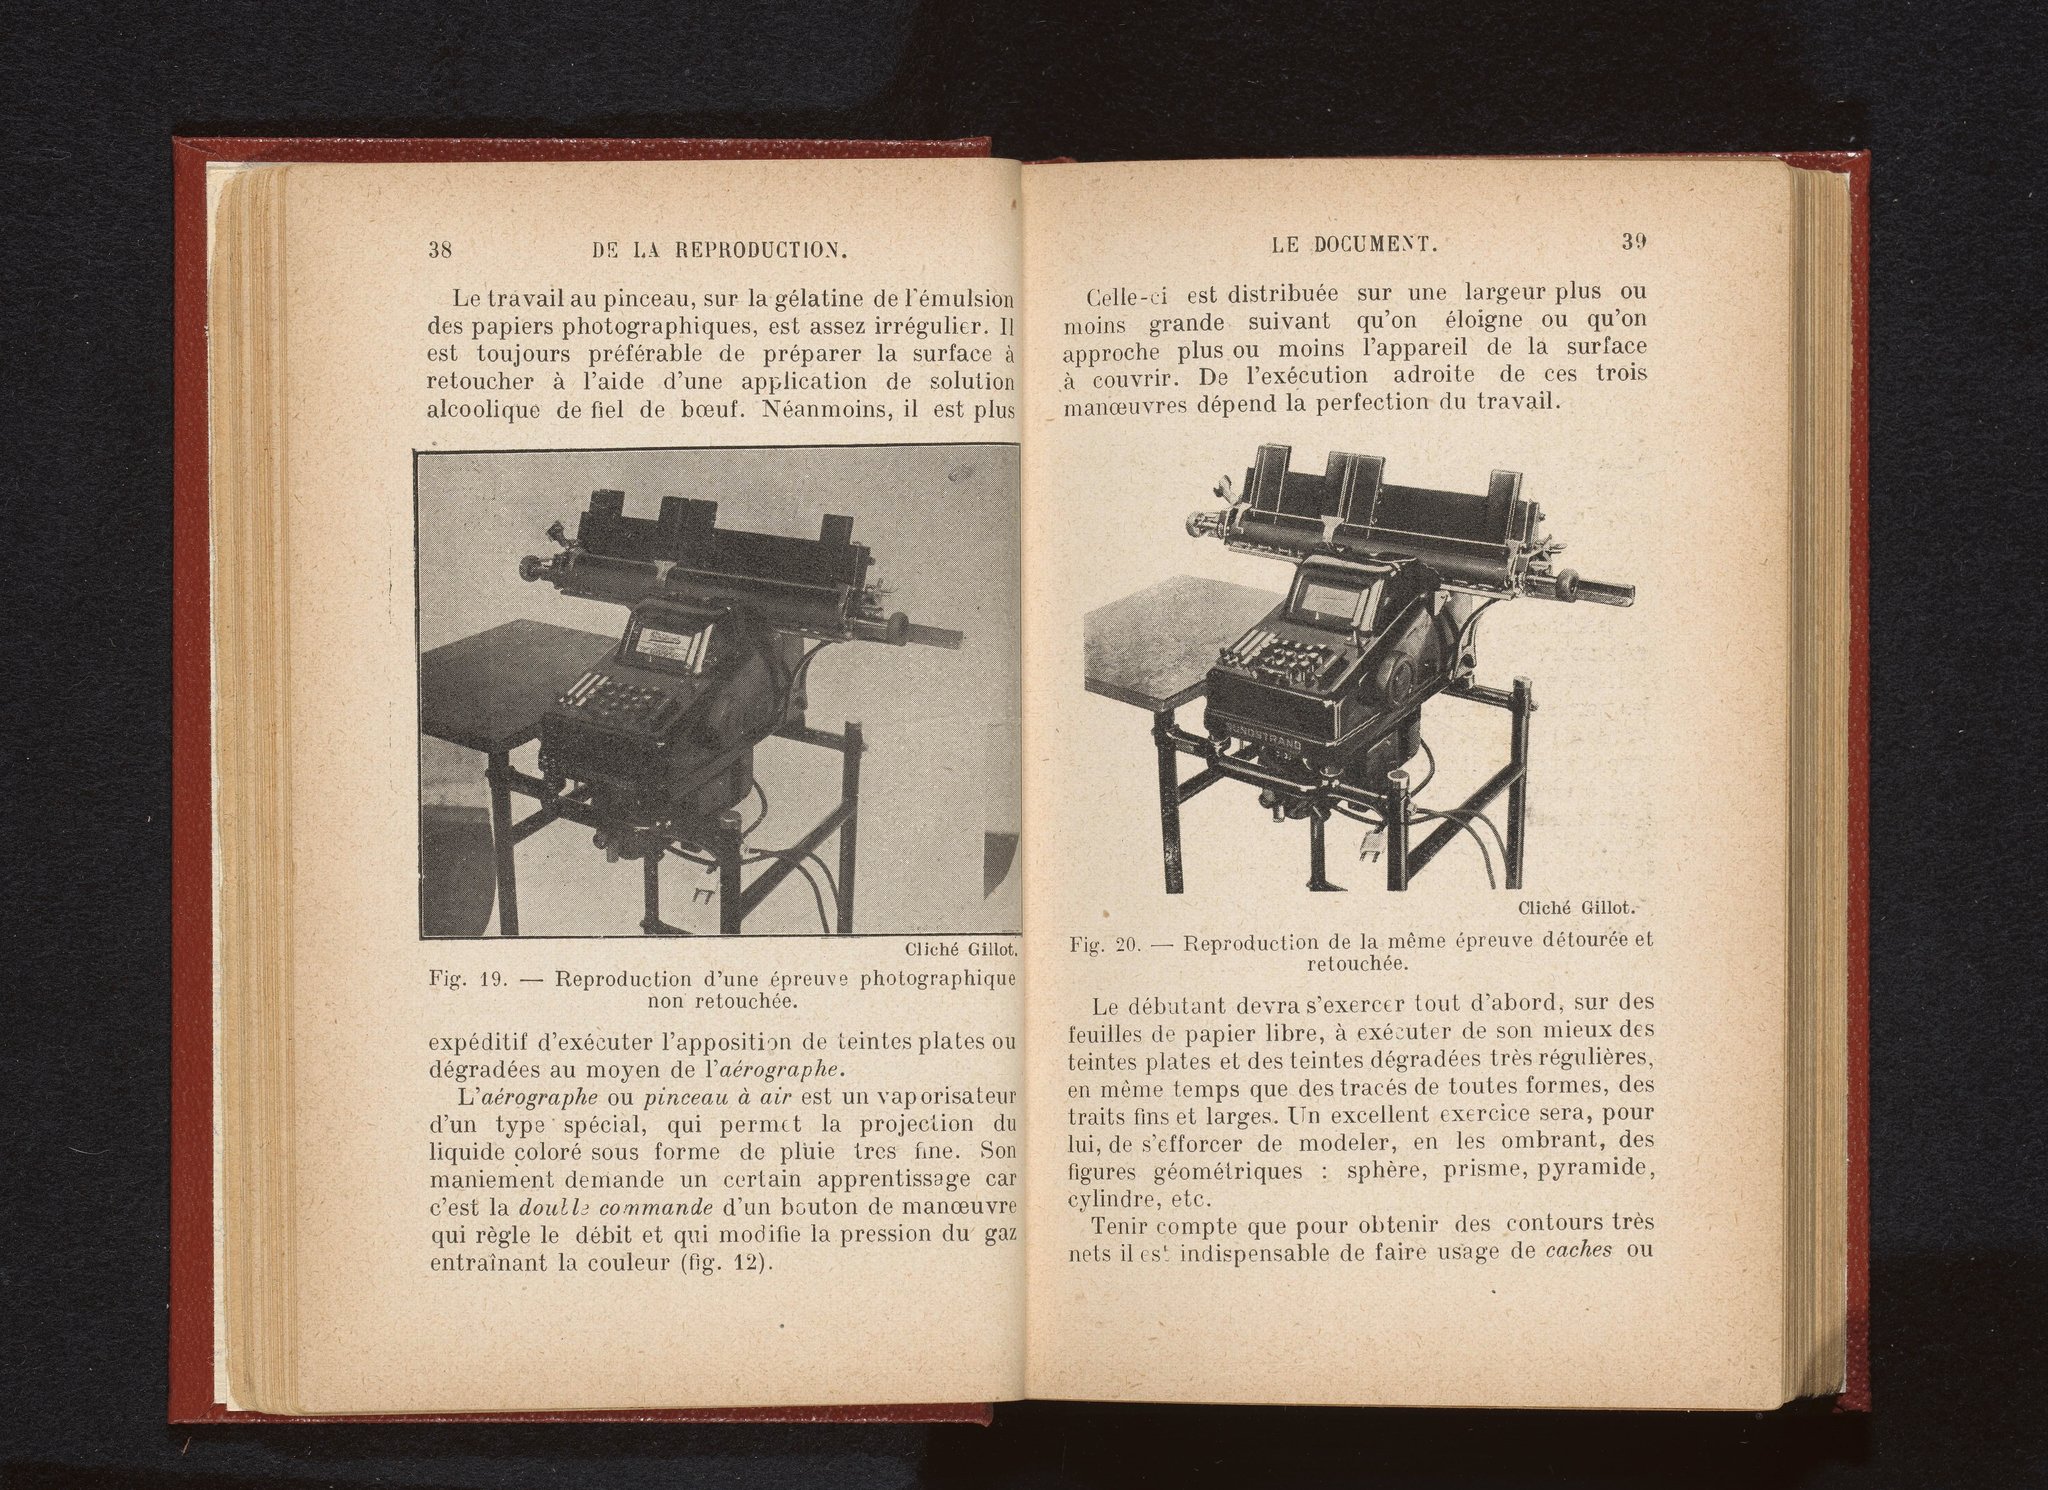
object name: photomechanical print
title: Reproduction d'une épreuve photographique non retouchée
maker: Anonymous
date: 1922-1932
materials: paper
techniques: autotype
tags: photographic apparatus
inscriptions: number: ‘Fig. 19.’